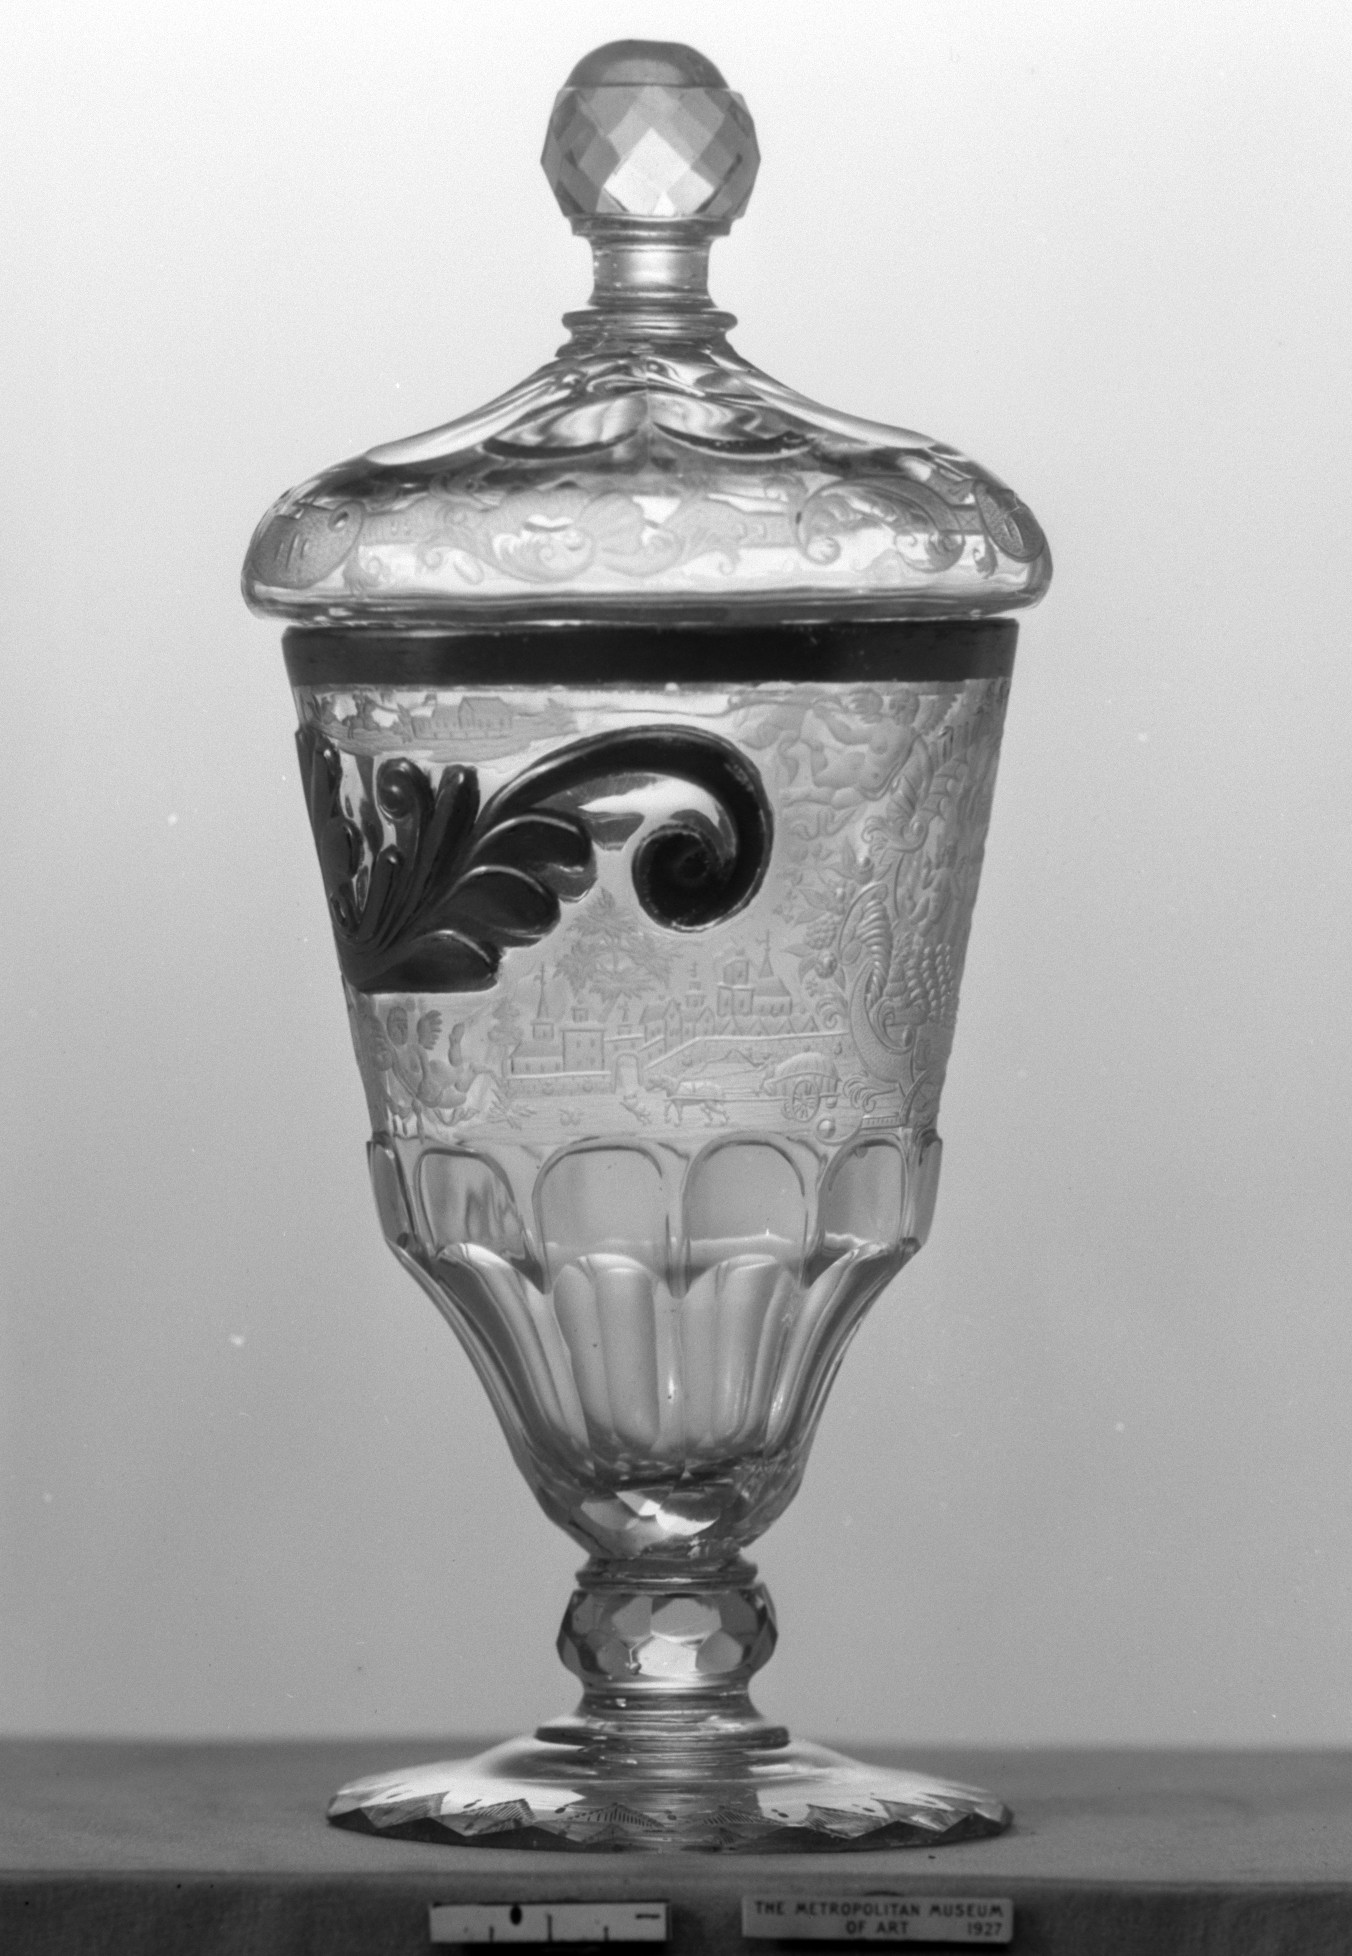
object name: standing cup with cover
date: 1750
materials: glass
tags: putti,horses,carts